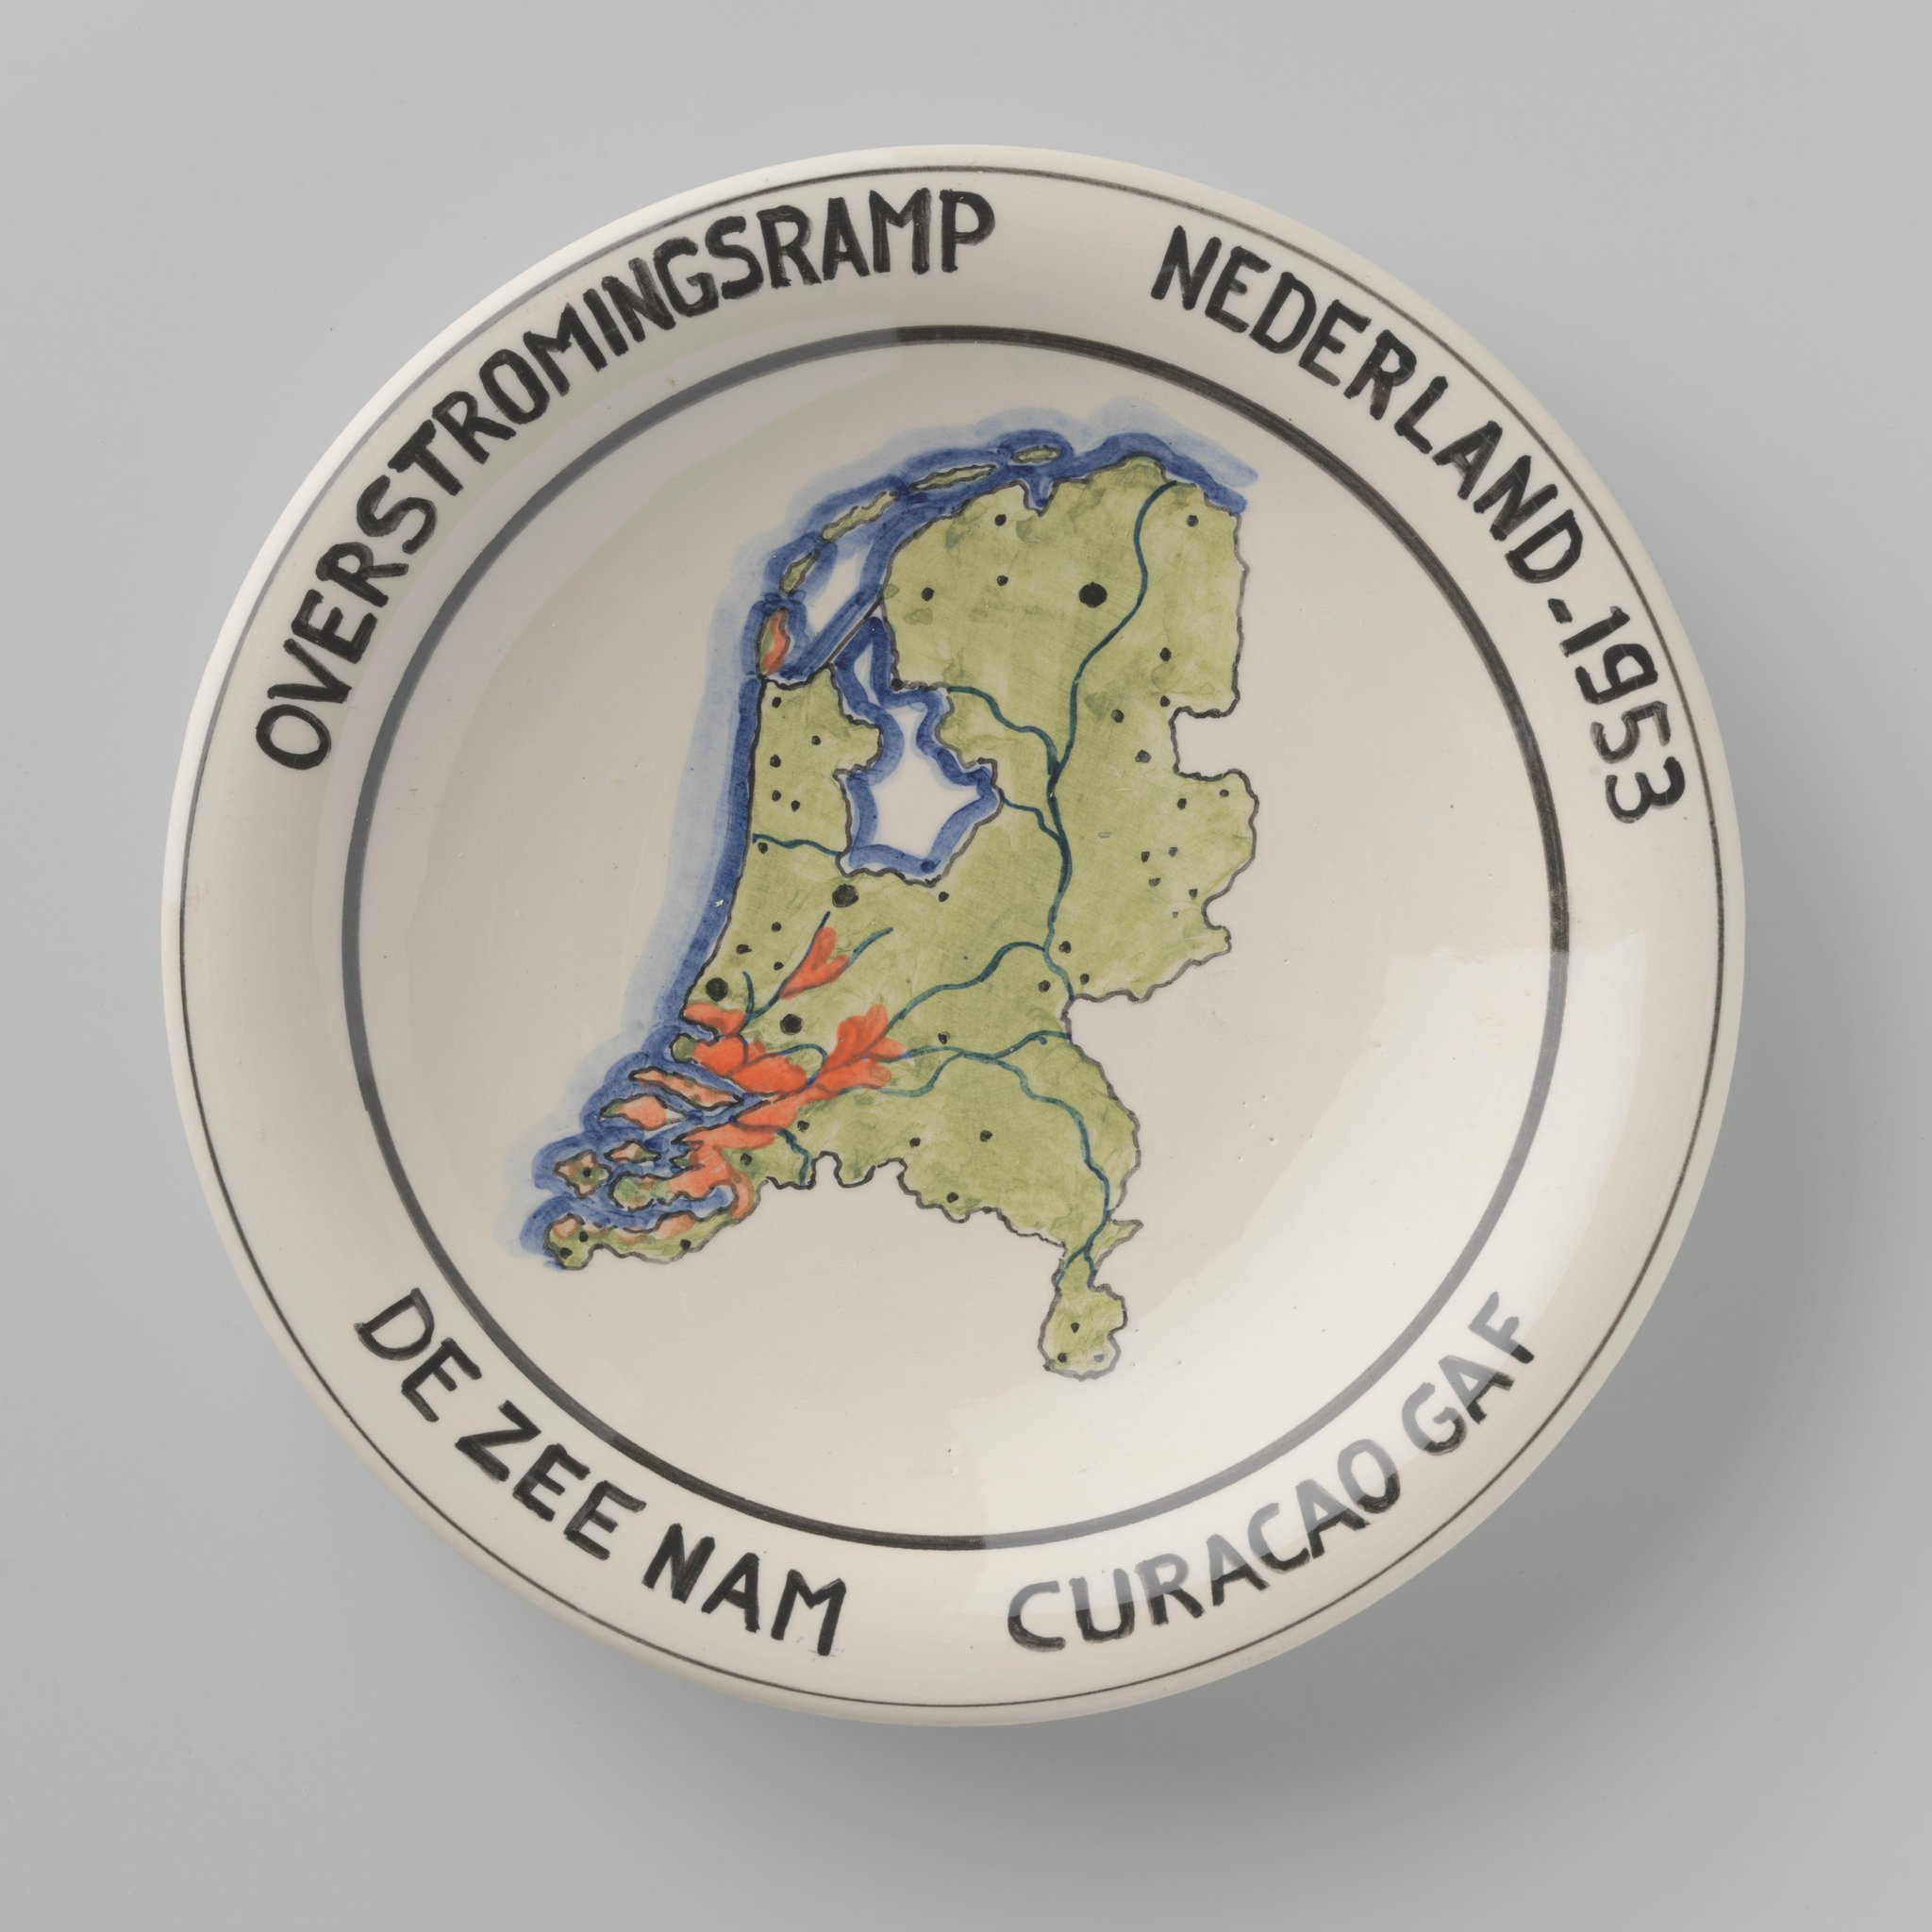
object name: wandbord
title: Wandbordje hulp van Curaçao aan Nederland na de Watersnoodramp 1953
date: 1953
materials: earthenware, porcelain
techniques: painted, vitrification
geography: curacao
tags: zeeland, north sea flood of 1953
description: Wandbordje watersnoodramp 1953 in Nederland. Het bordje werd in Curaçao gemaakt en verkocht ten bate van de slachtoffers van de ramp. Opschrift: OVERSTROMINGSRAMP NEDERLAND-1953 / DE ZEE NAM CURACAO GAF. Op het bordje de kaart van Nederland in groen met in rood aangegeven de overstroomde gebieden. Keerzijde opschrif: 74 'EERSTE CURAÇAOSE AARDEWERKFABRIEK 'E.C.A.F'.